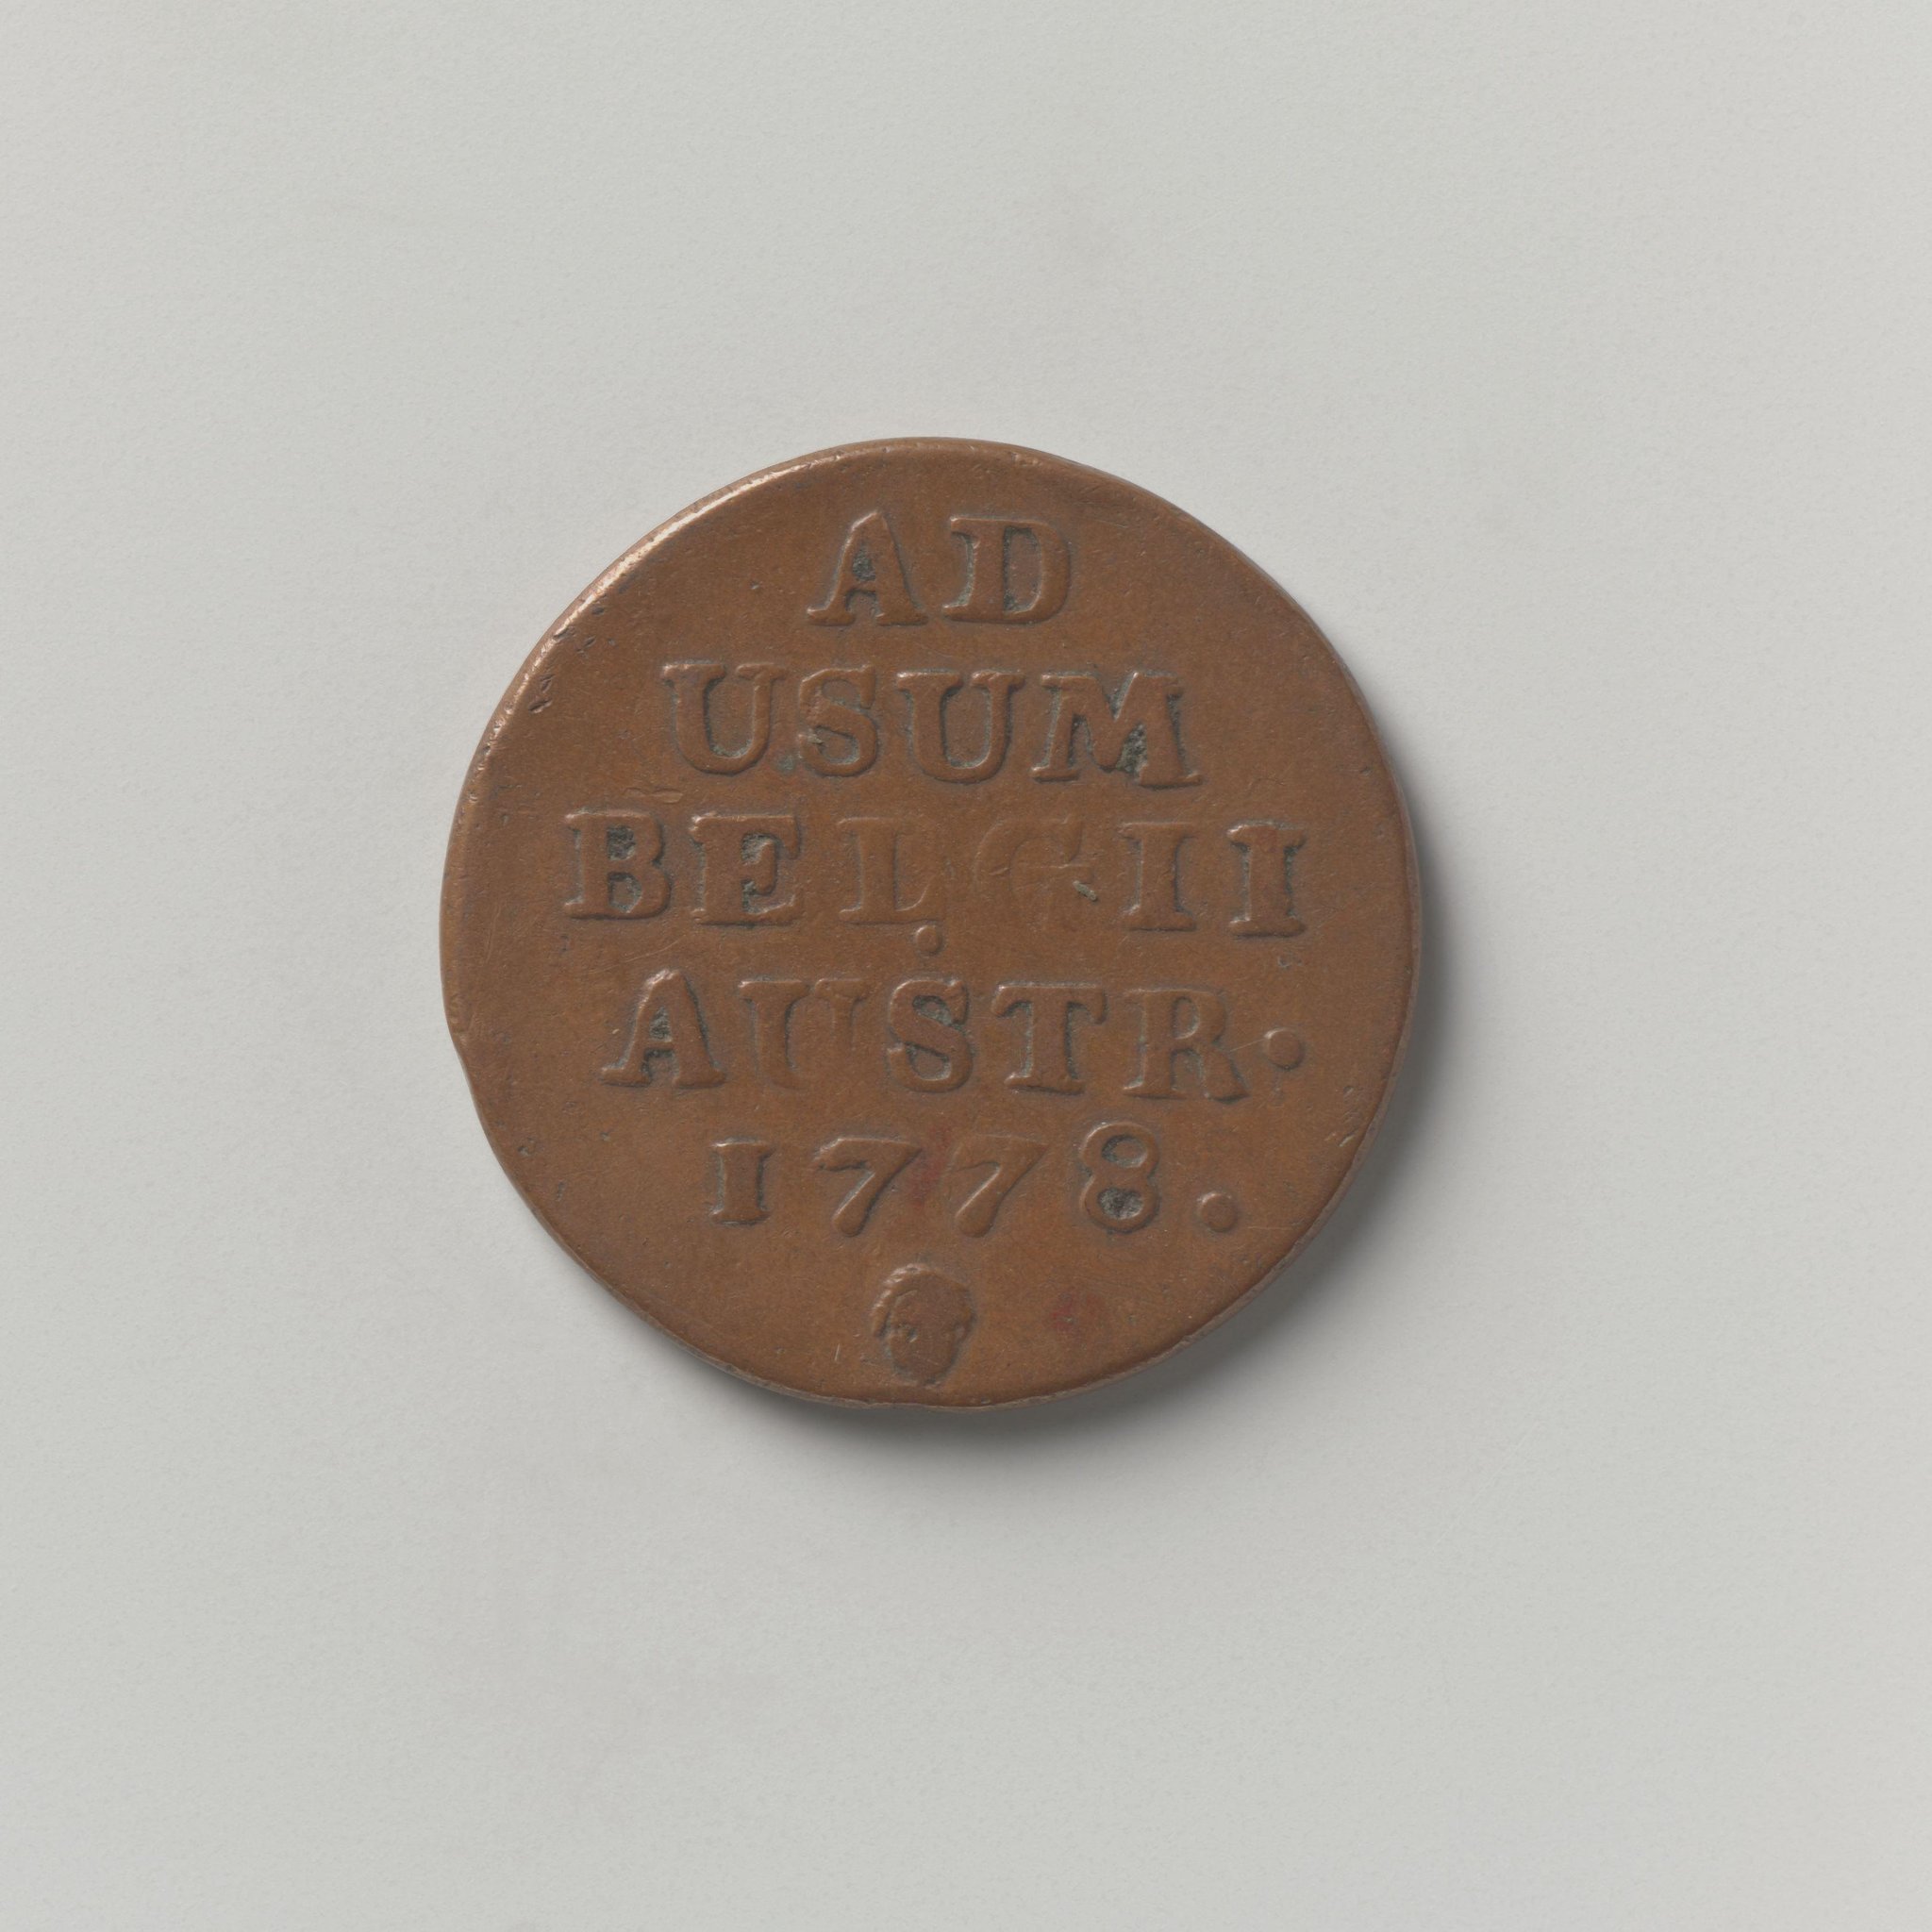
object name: oord, oortje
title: Oord uit Brabant van Maria-Theresia,1778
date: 1778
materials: copper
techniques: striking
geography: brussels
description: Koperen munt. Voorzijde: portret van Maria-Theresia naar rechts. Keerzijde: vierregelig opschrift, waaronder jaartal. Daaronder engelenkop.